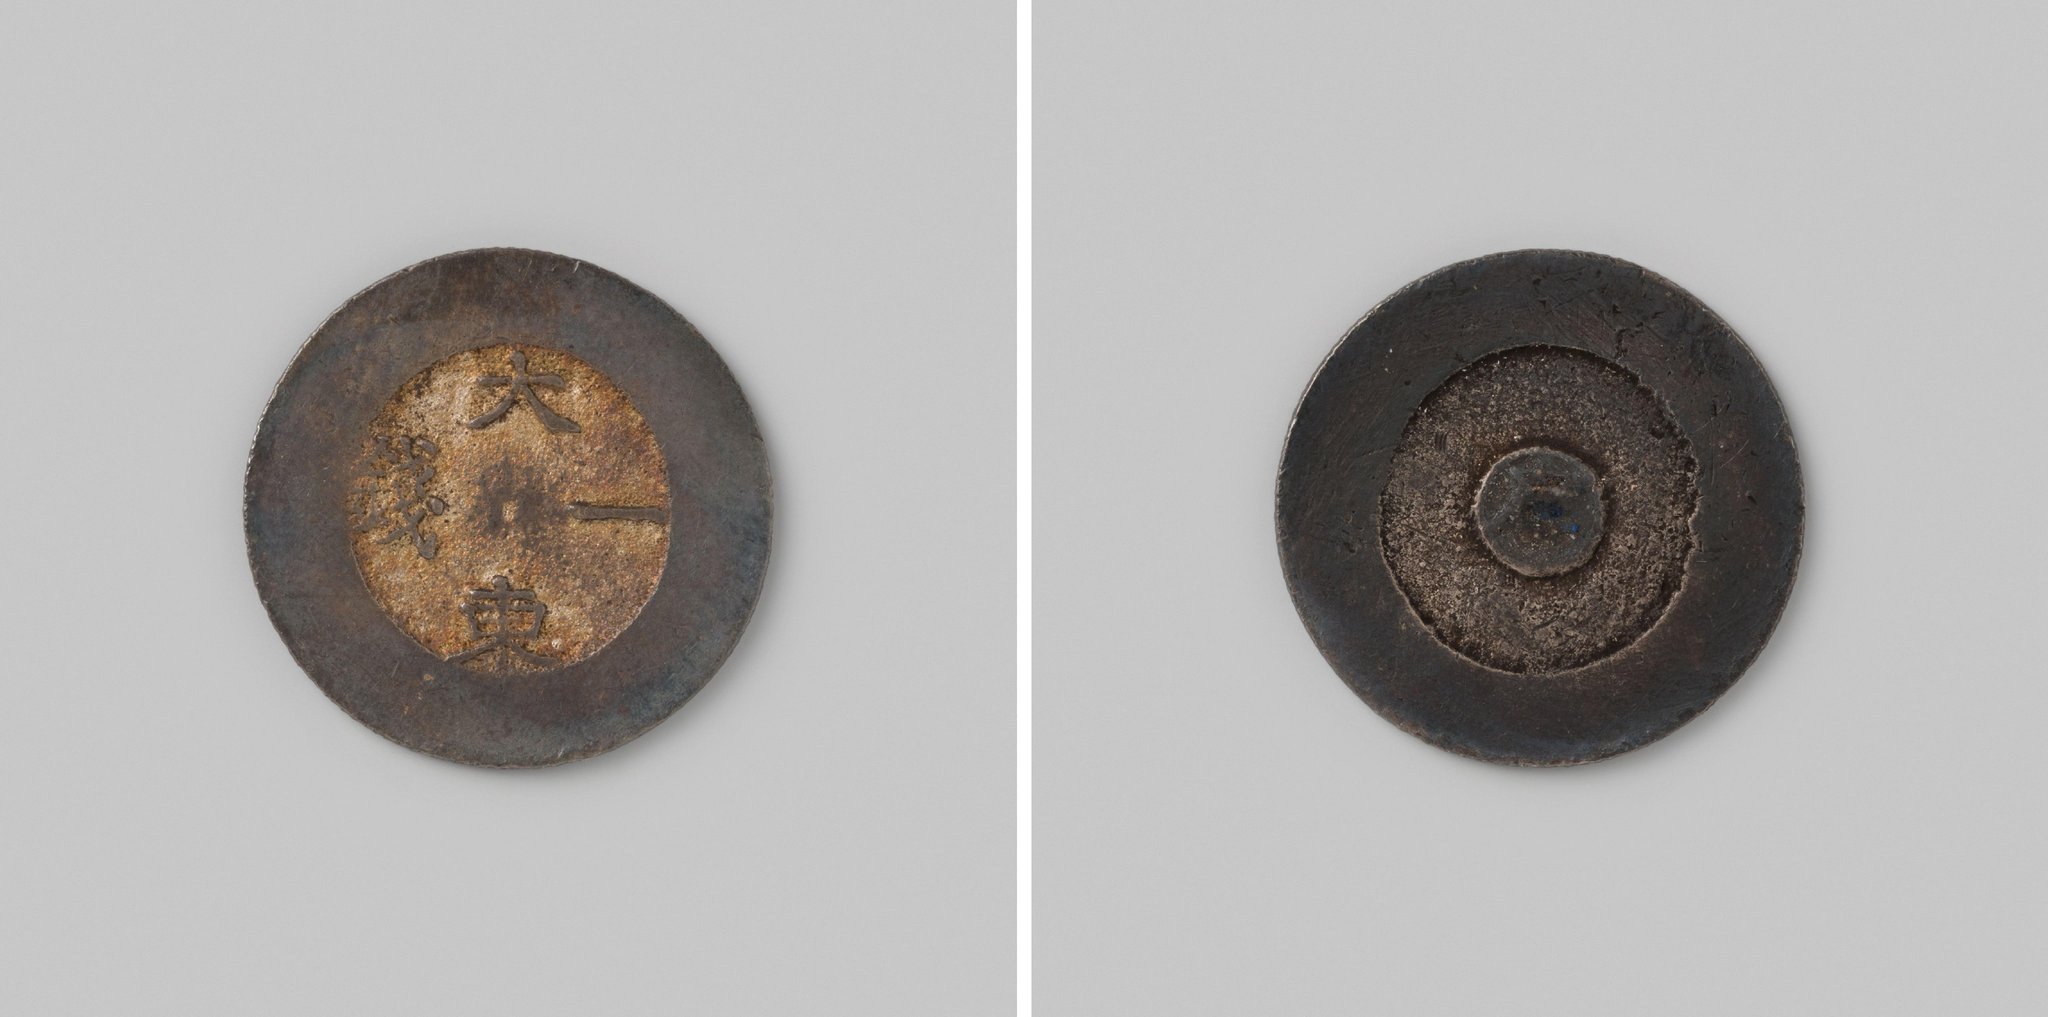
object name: coin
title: Chon uit het koninkrijk Korea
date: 1882-1883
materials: silver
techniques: striking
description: Zilveren munt. Voorzijde: binnen brede, gladde rand drie tekens, boven onder en links, tezamen betekenend: [rijk van het] Grote Oosten. Rechts waarde-aanduiding: 1 door middel van een liggende streep. Keerzijde: binnen brede, gladde rand kleine cirkel, waarop blauw email is aangebracht. In het email Chinese teken: ho [=ministerie van] financiën. Gladde rand,